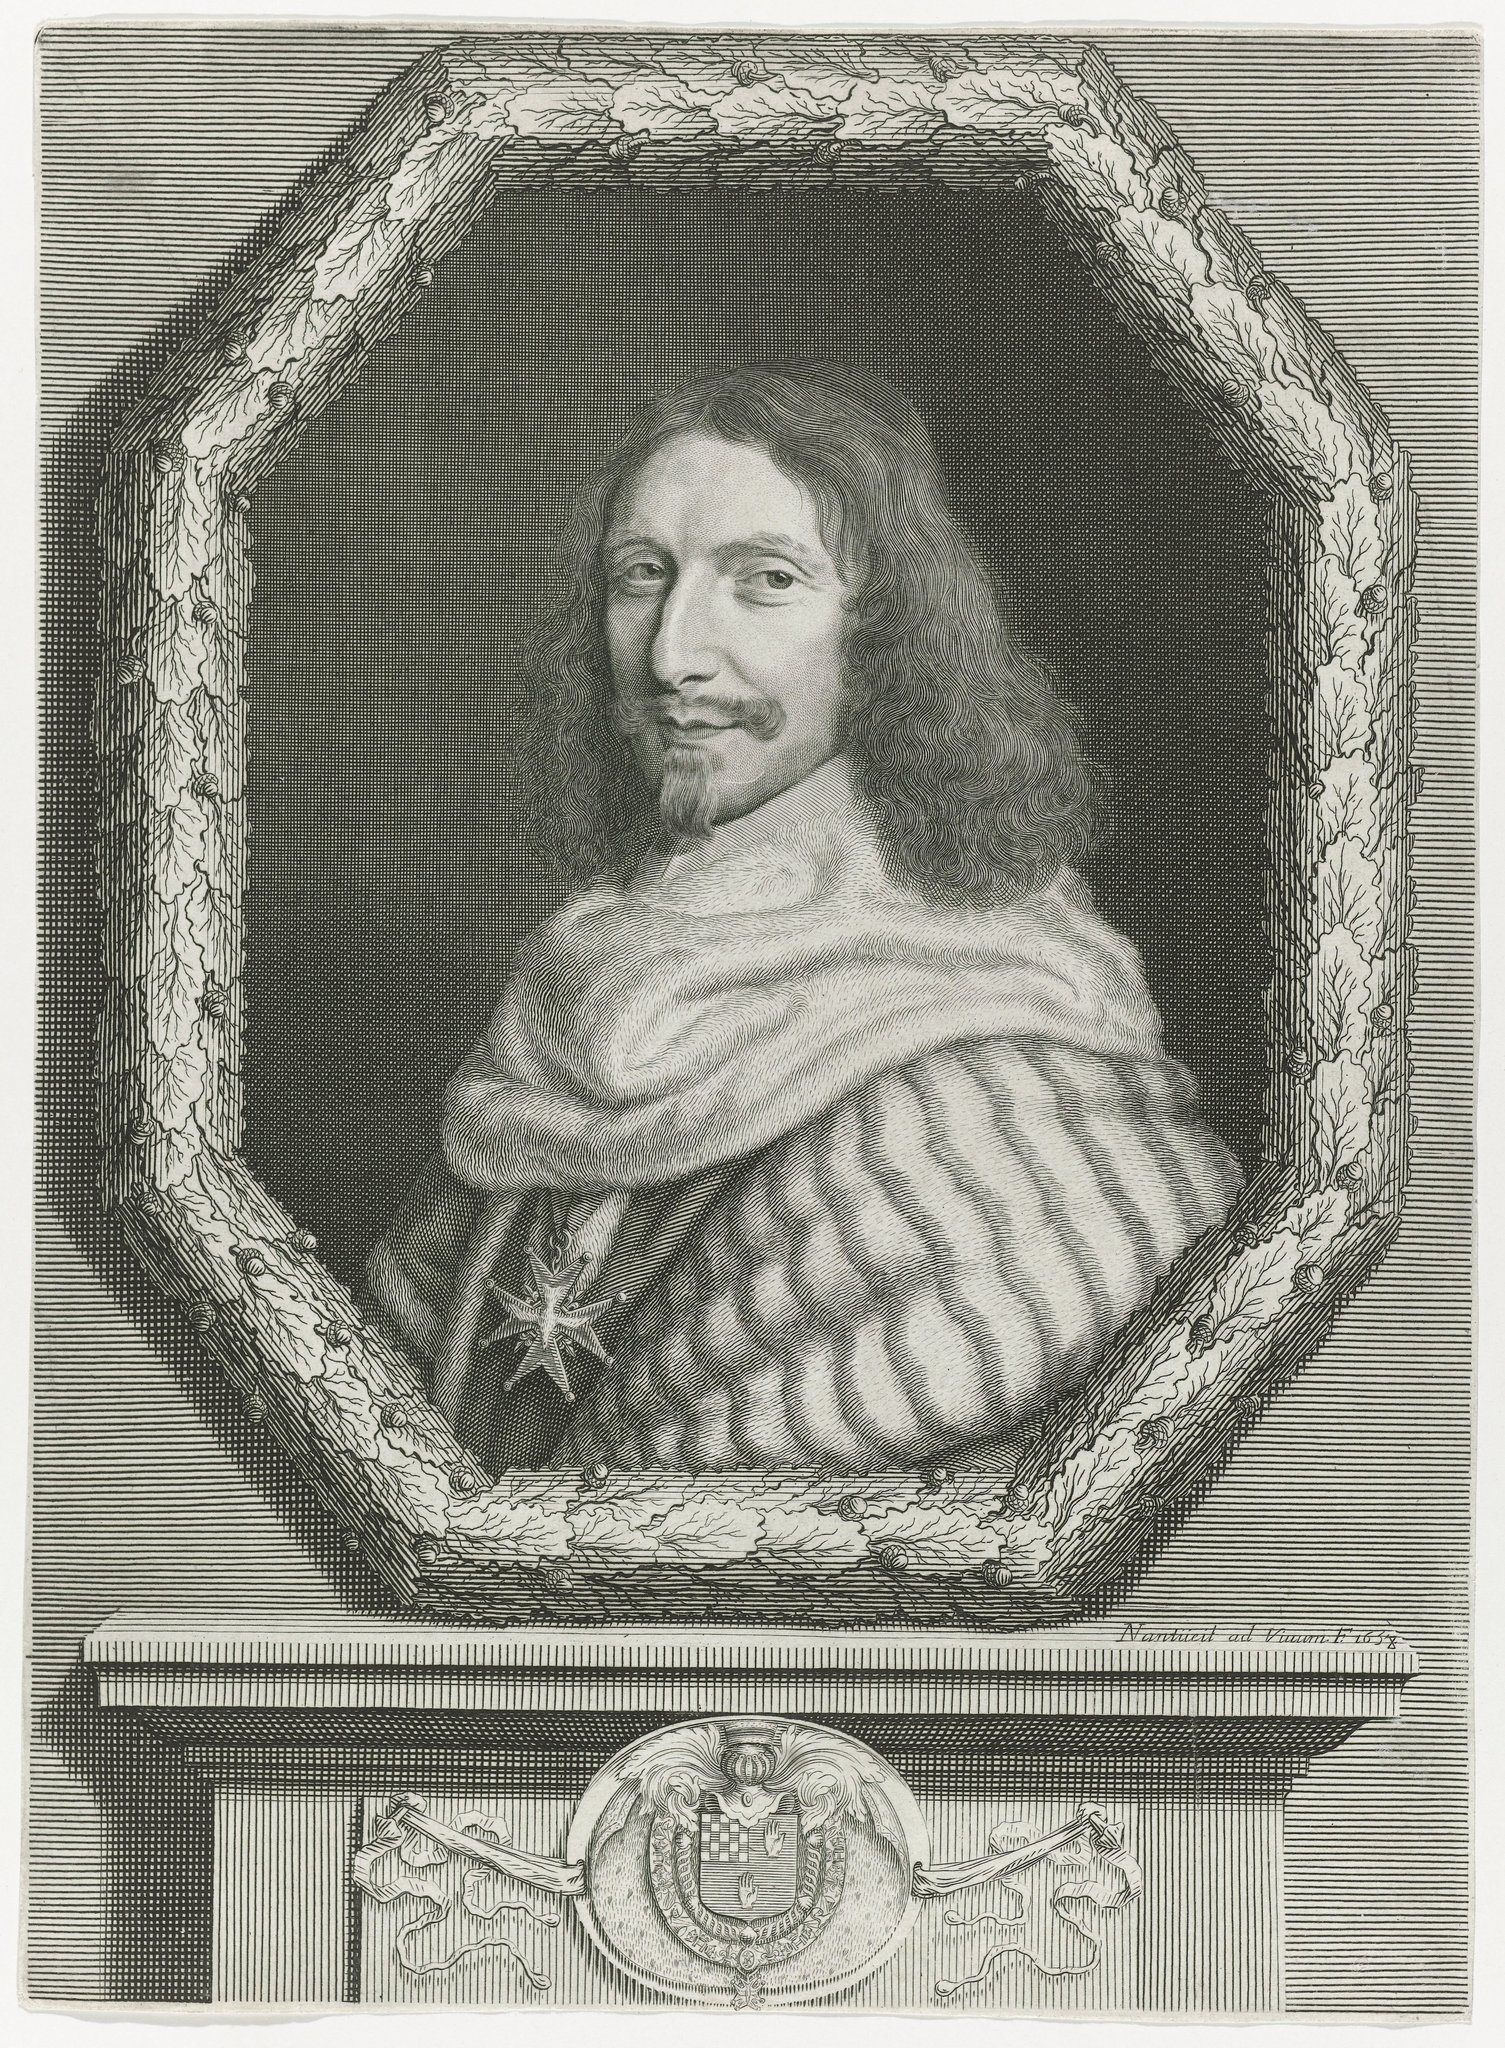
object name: print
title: Portret Nicolas Potier de Novion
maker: robert nanteuil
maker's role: print maker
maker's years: 1623-1678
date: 1658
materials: paper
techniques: engraving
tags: staatsman, nicolas potier de novion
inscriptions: date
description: Buste naar links, met brede bontkraag, in octagonale lijst. Wapen middenonder